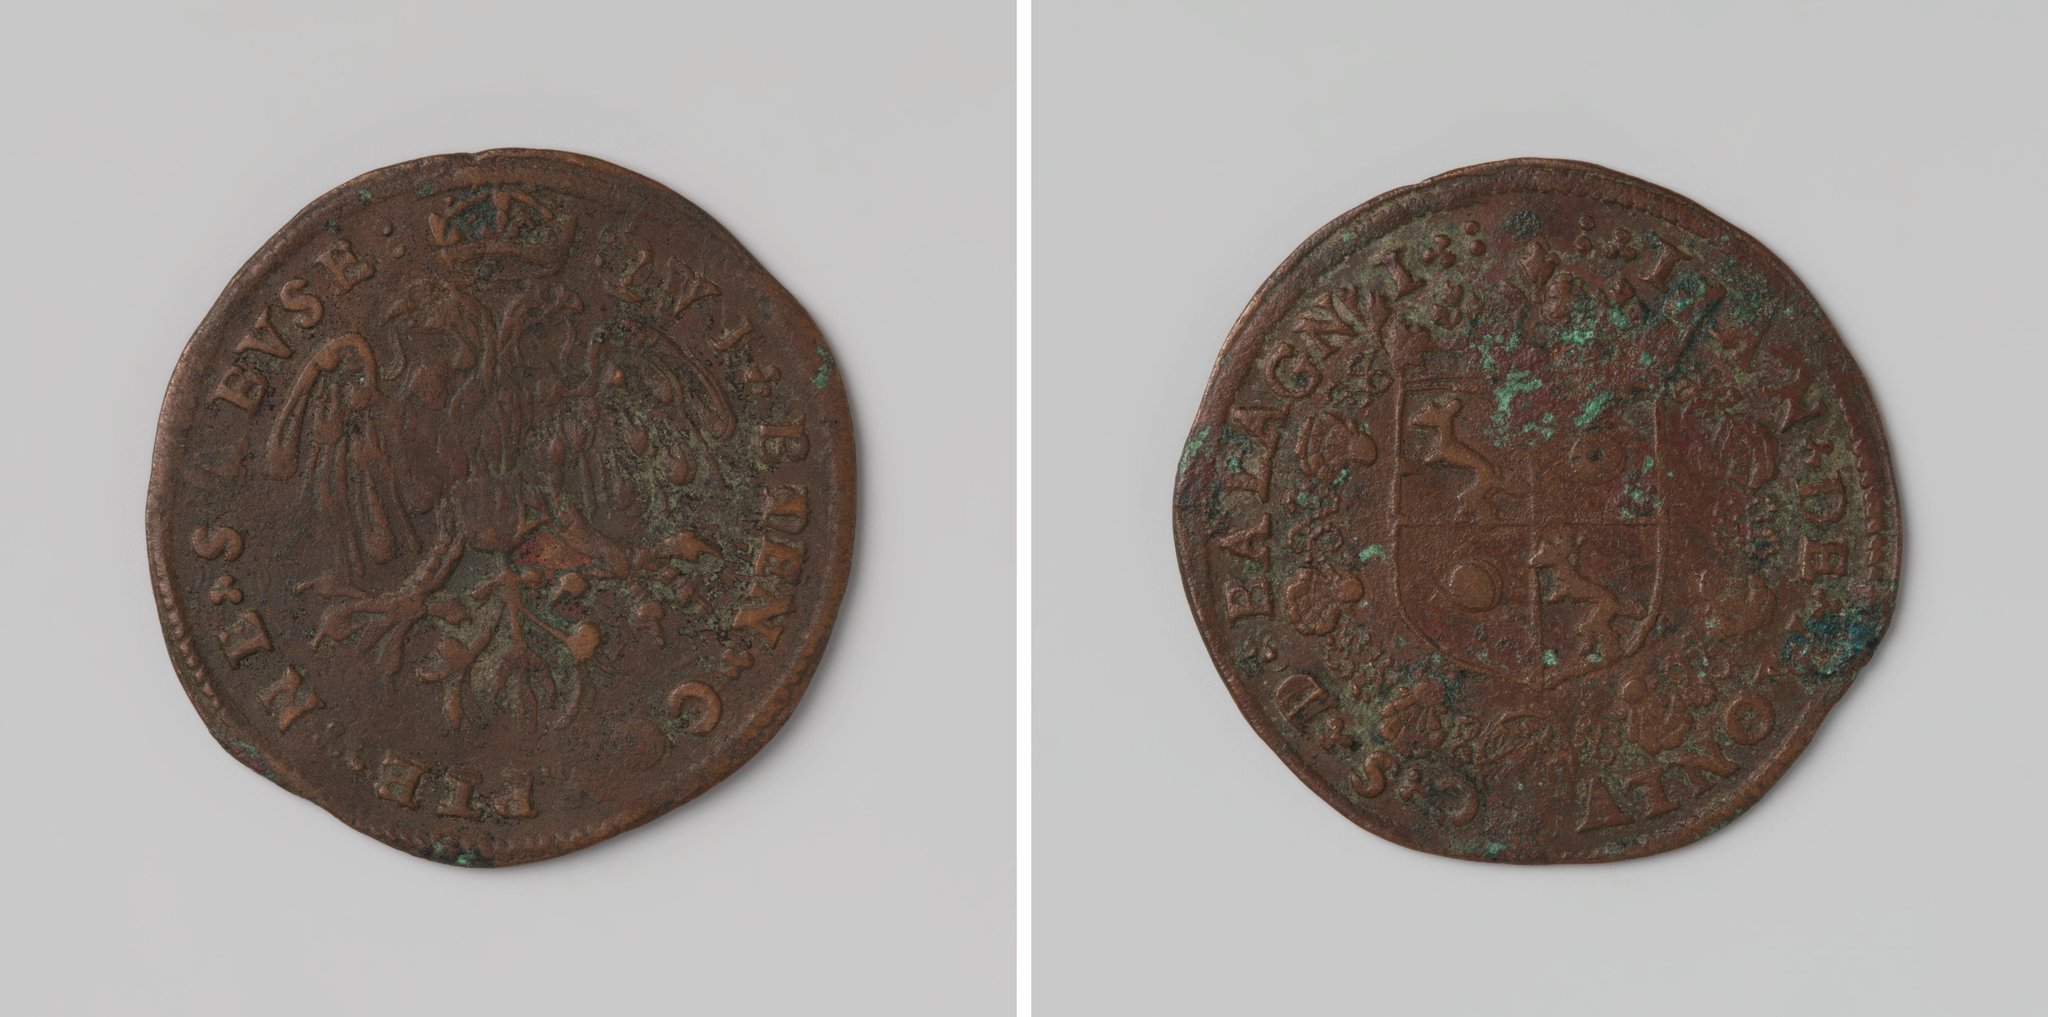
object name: jeton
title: Jean de Monluc, heer van Baligny, stadvoogd van Kamerijk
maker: Anonymous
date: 1589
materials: copper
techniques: striking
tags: jean de monluc, cambrai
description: Koperen penning. Voorzijde: tweekoppige adelaar met wapenschild op borst onder kroon binnen omschrift. Keerzijde: gekroond wapenschild, omhangen met de orde van St. Michel binnen omschrift